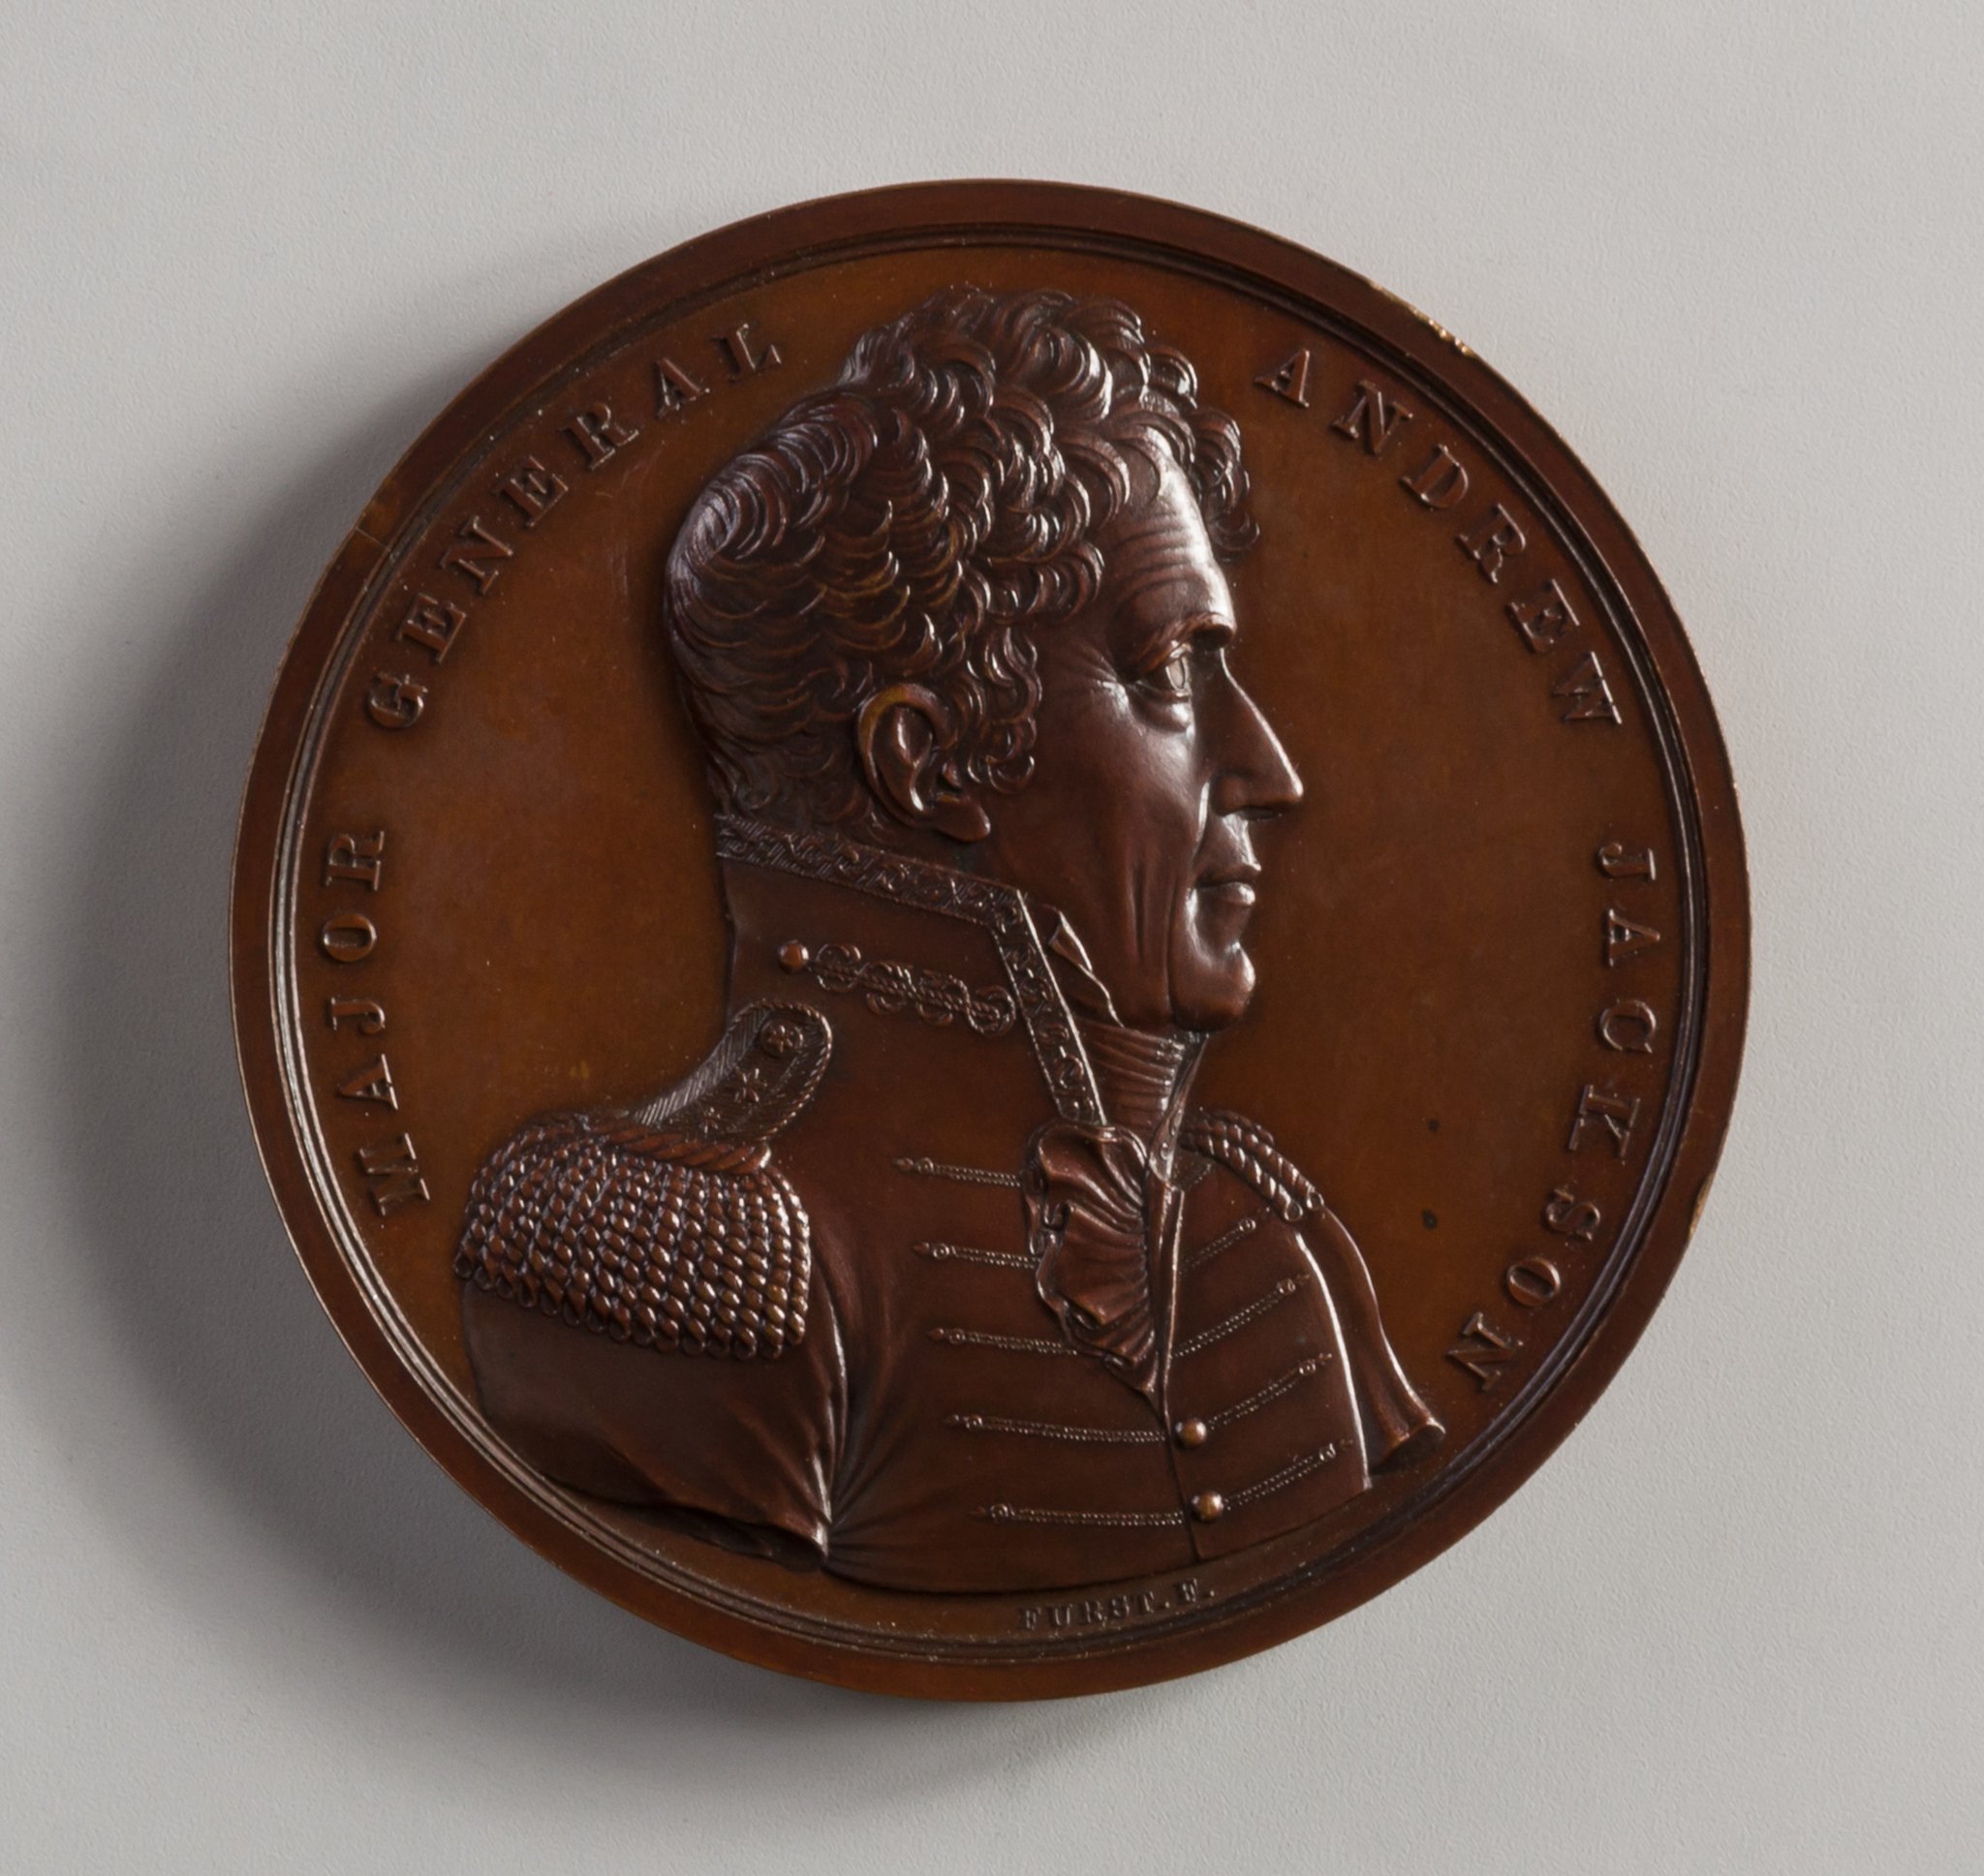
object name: medal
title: Medal of Major General Andrew Jackson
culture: american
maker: moritz fürst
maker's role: maker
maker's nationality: hungarian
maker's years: 1782-1882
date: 1800-1830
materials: bronze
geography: united states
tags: men,profiles